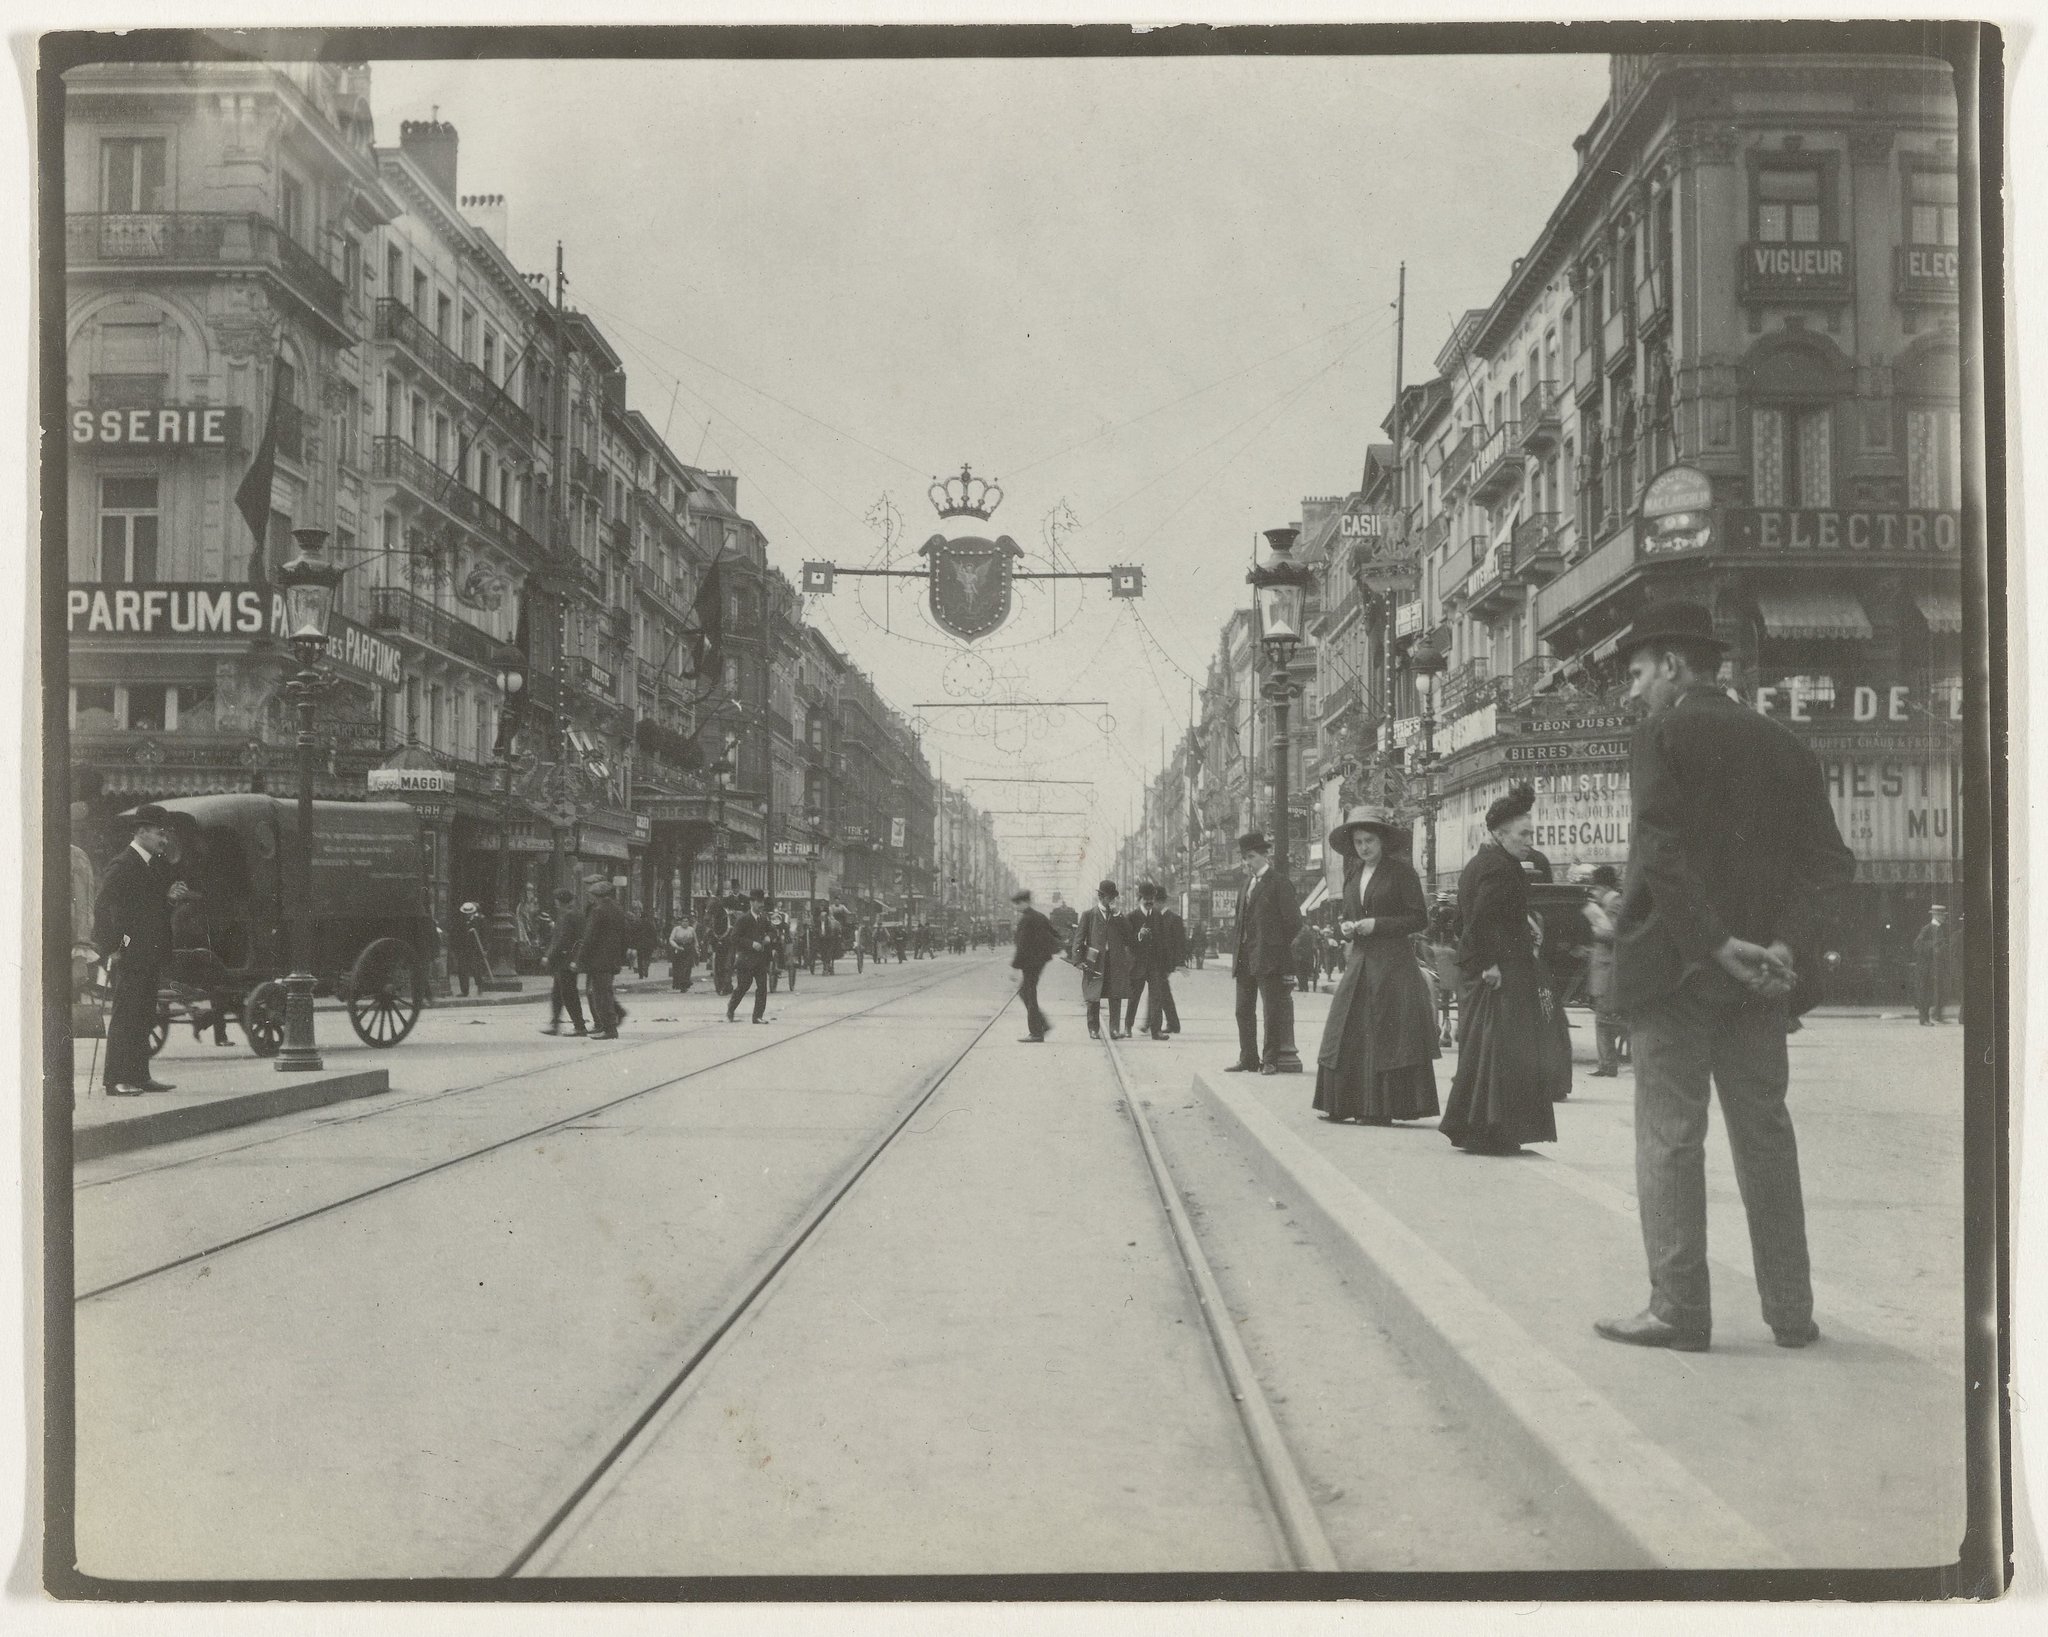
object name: photograph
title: Anspachlaan te Brussel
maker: Anonymous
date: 1900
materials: paper, photographic support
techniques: gelatin silver print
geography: belgium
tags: tramway, tram, street (+ city(-scape) with figures, staffage), brussels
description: De Anspachlaan te Brussel, vanuit de Beurs gezien naar het zuiden toe.